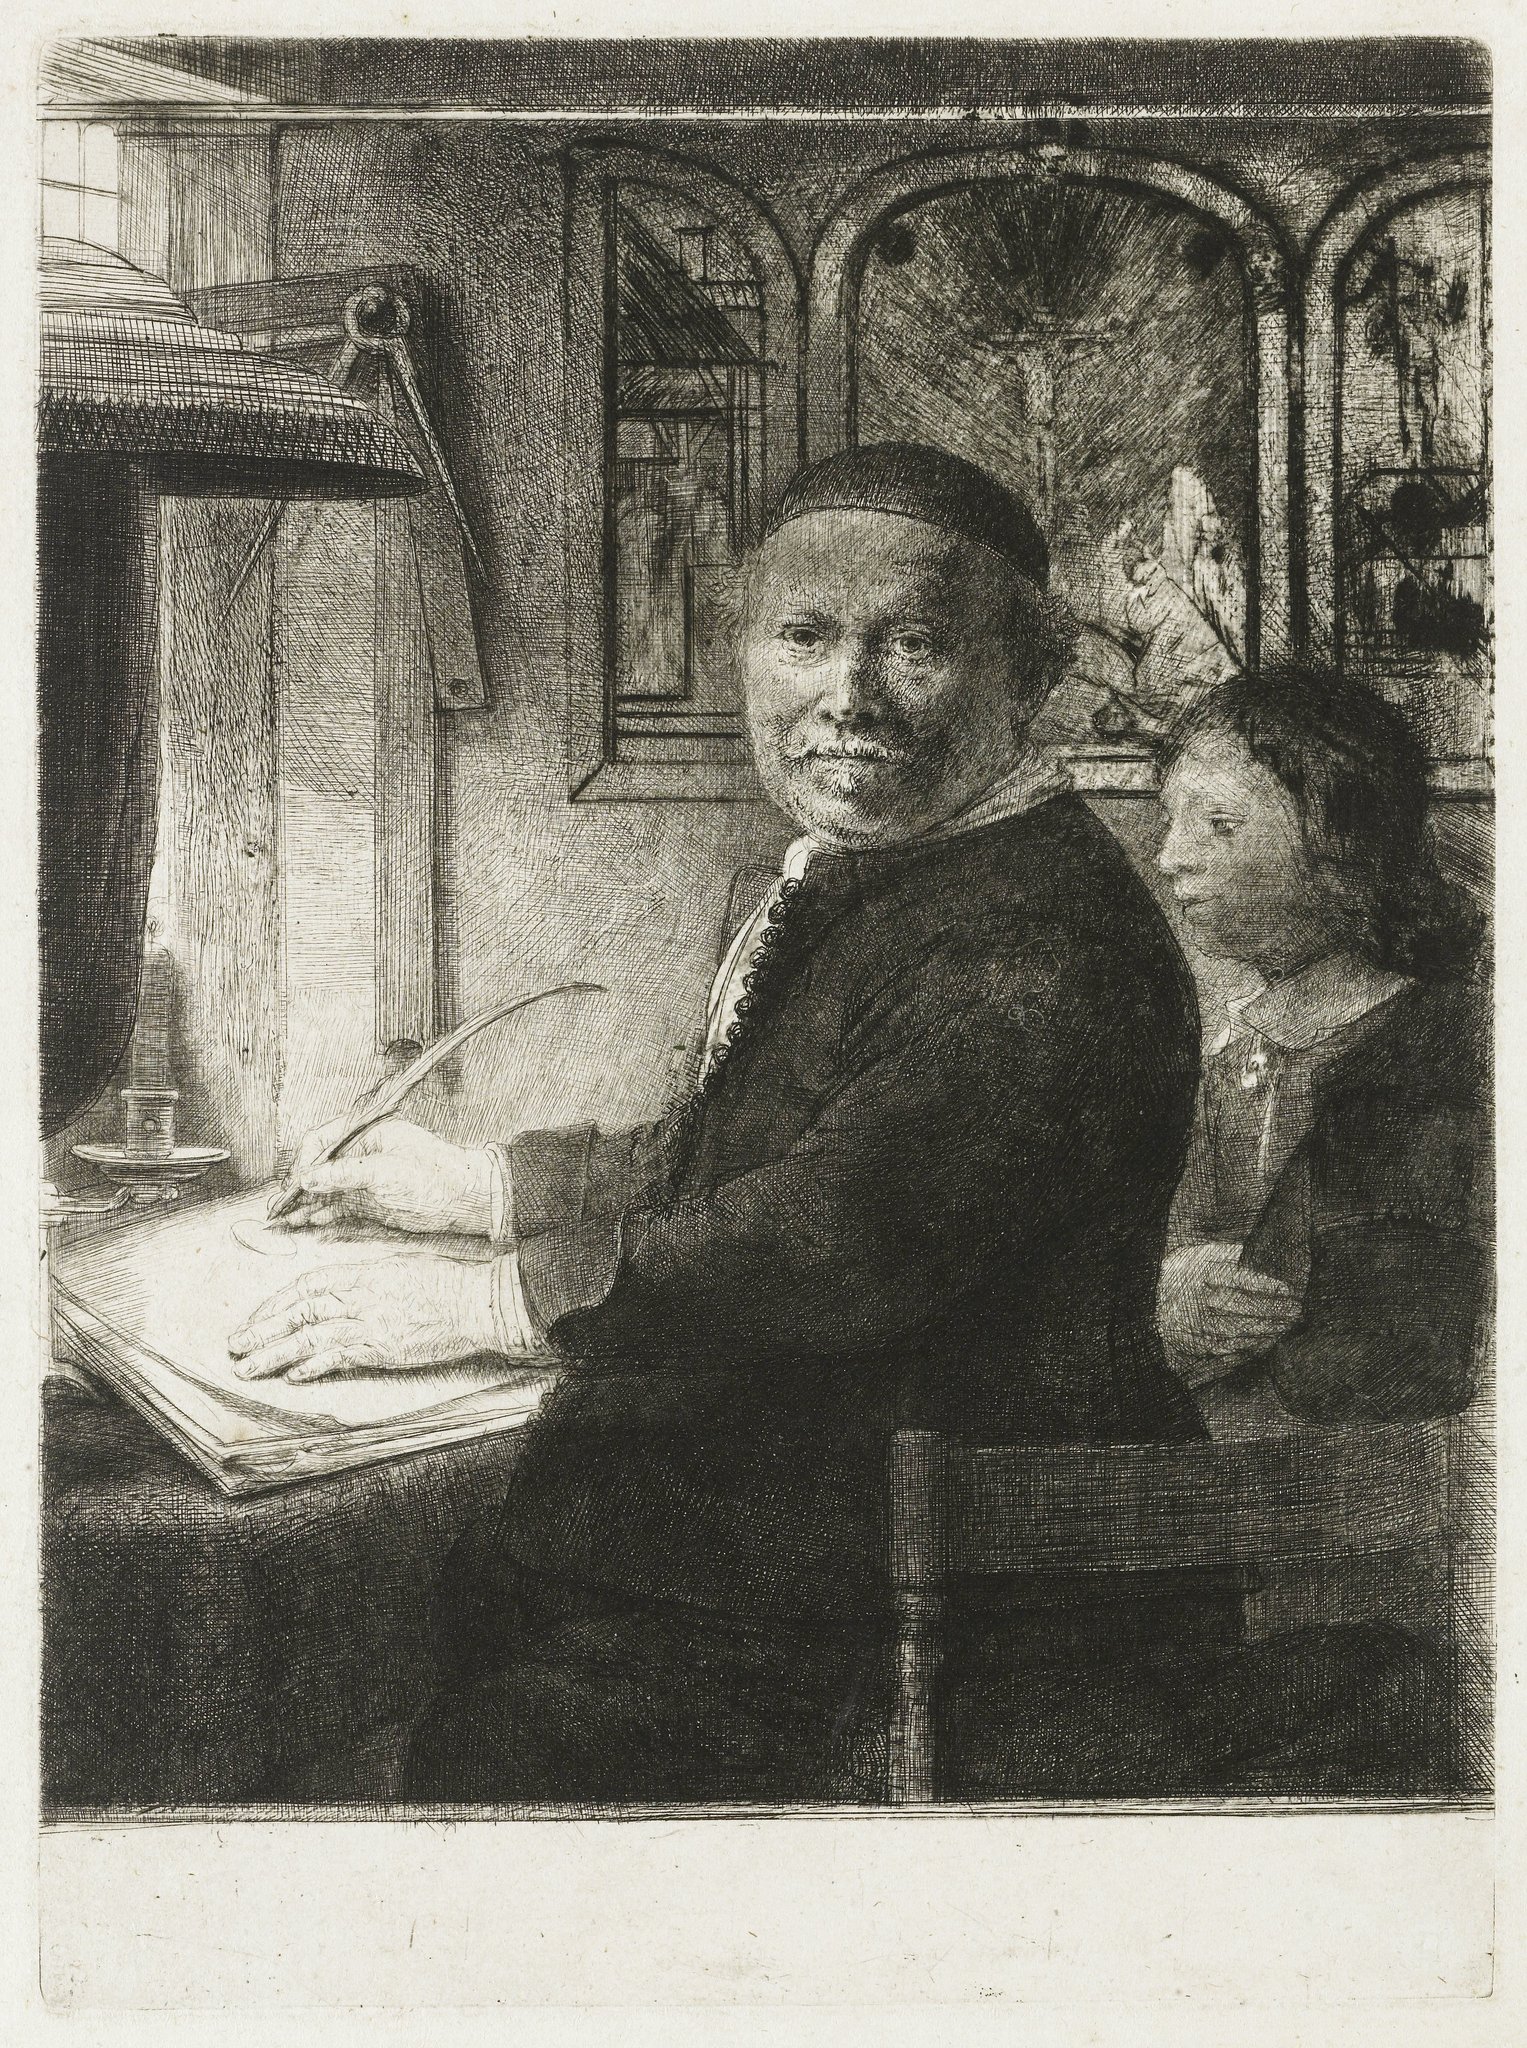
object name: print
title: Lieven Willemsz. van Coppenol, writing master: the smaller plate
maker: rembrandt van rijn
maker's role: draughtsman, painter, print maker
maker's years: 1606-1669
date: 1658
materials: paper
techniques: drypoint, etching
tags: amsterdam, draughtsman, lieven willemsz. coppenol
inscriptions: mark: Lugt 2228